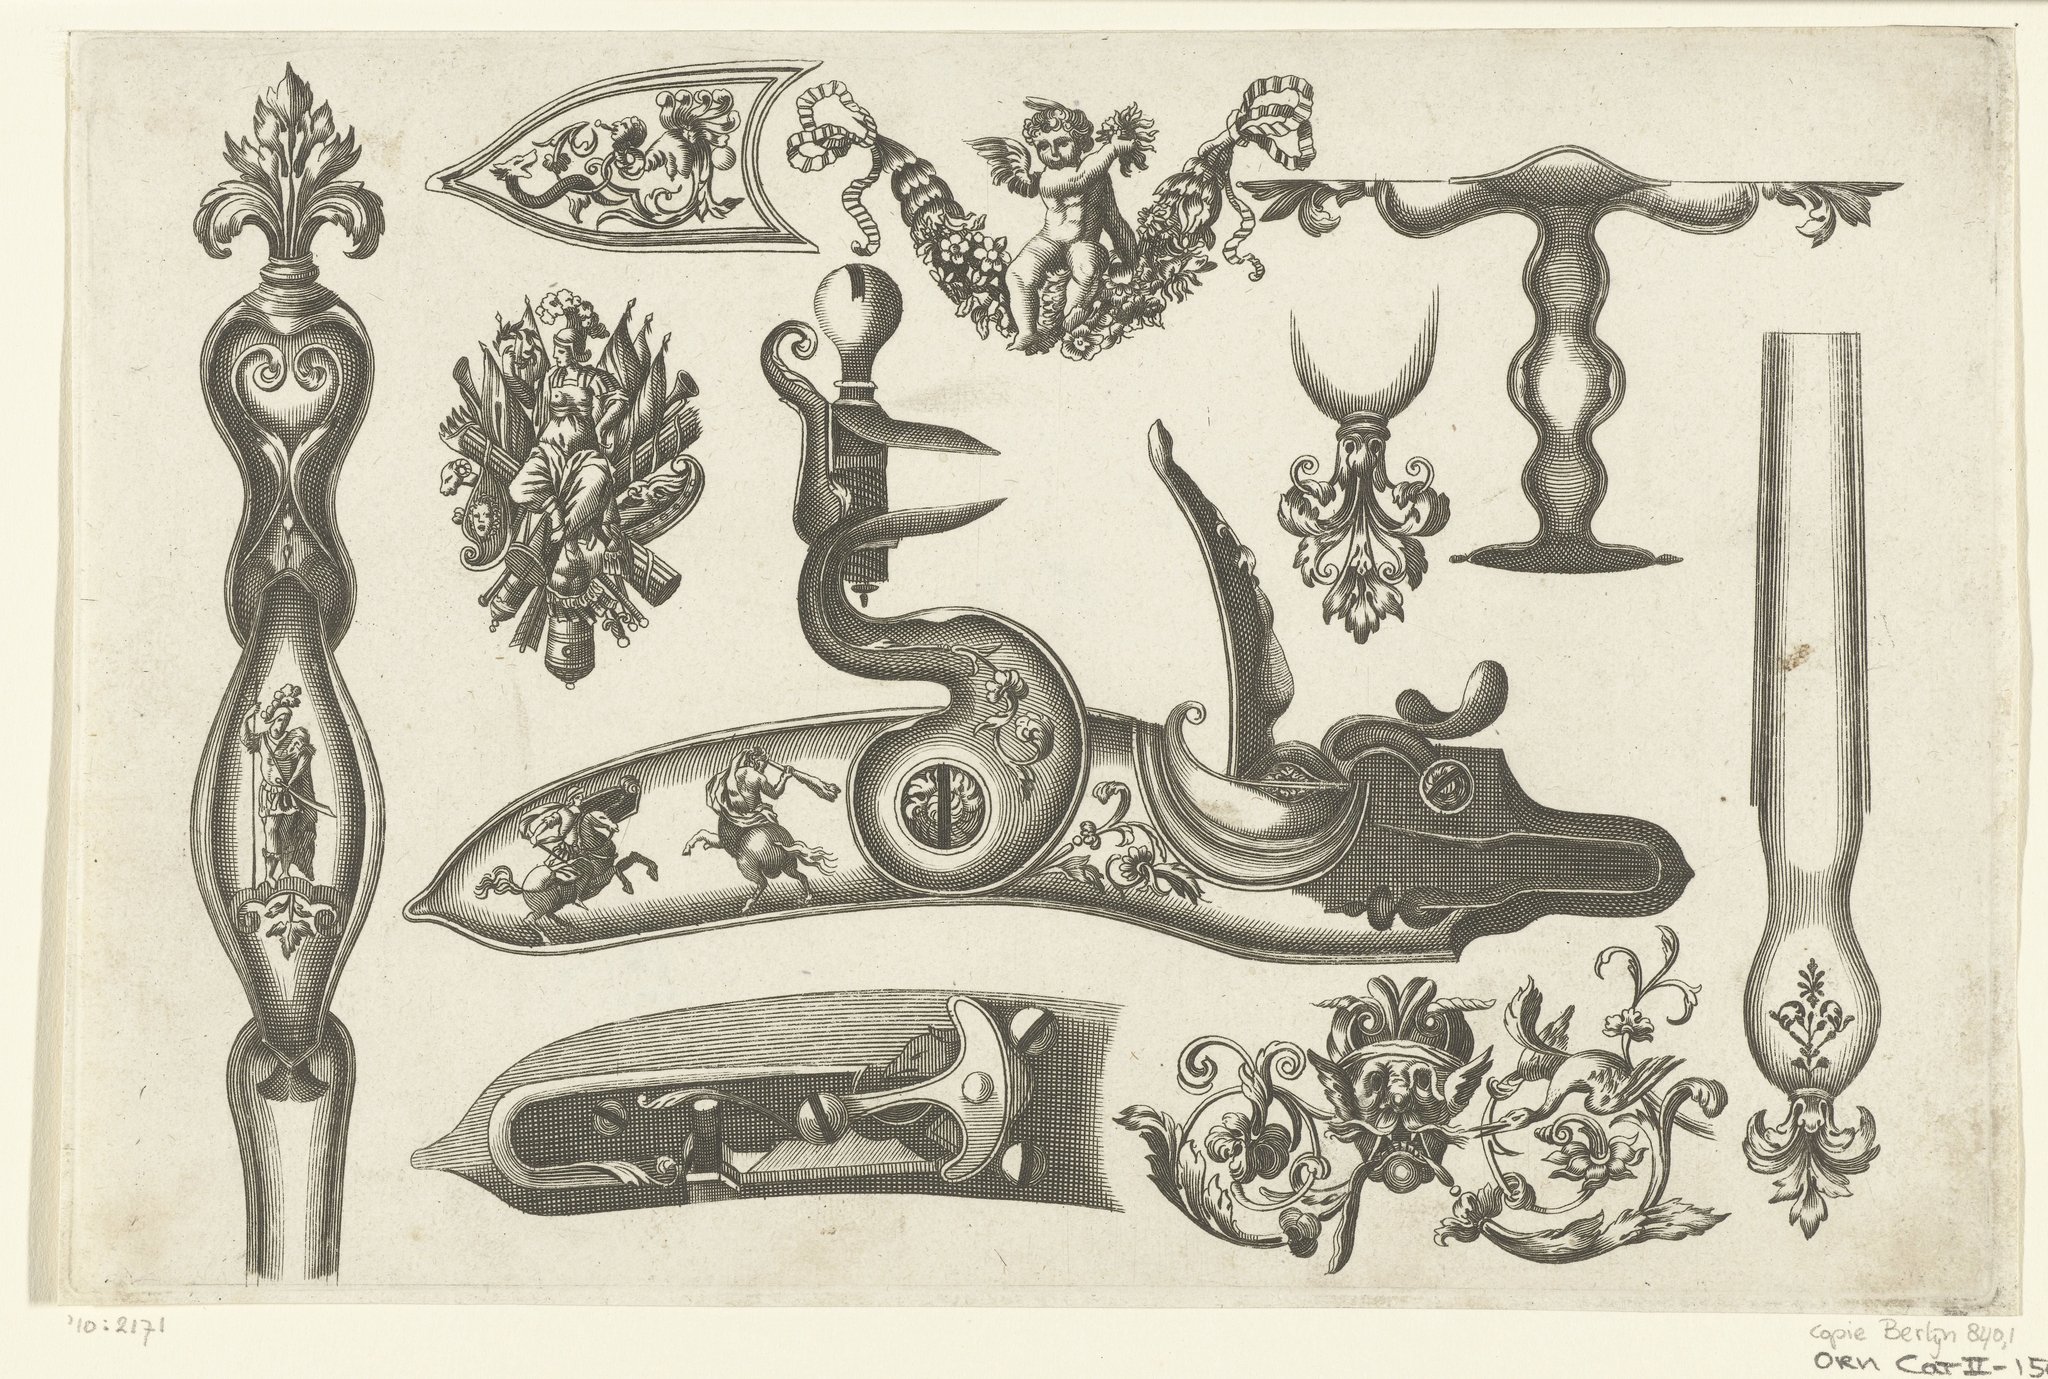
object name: ornament print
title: Tien affuiten en ornamenten voor geweren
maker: pieter schenk (i)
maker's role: print maker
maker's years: 1660-1711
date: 1692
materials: paper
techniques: engraving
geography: france